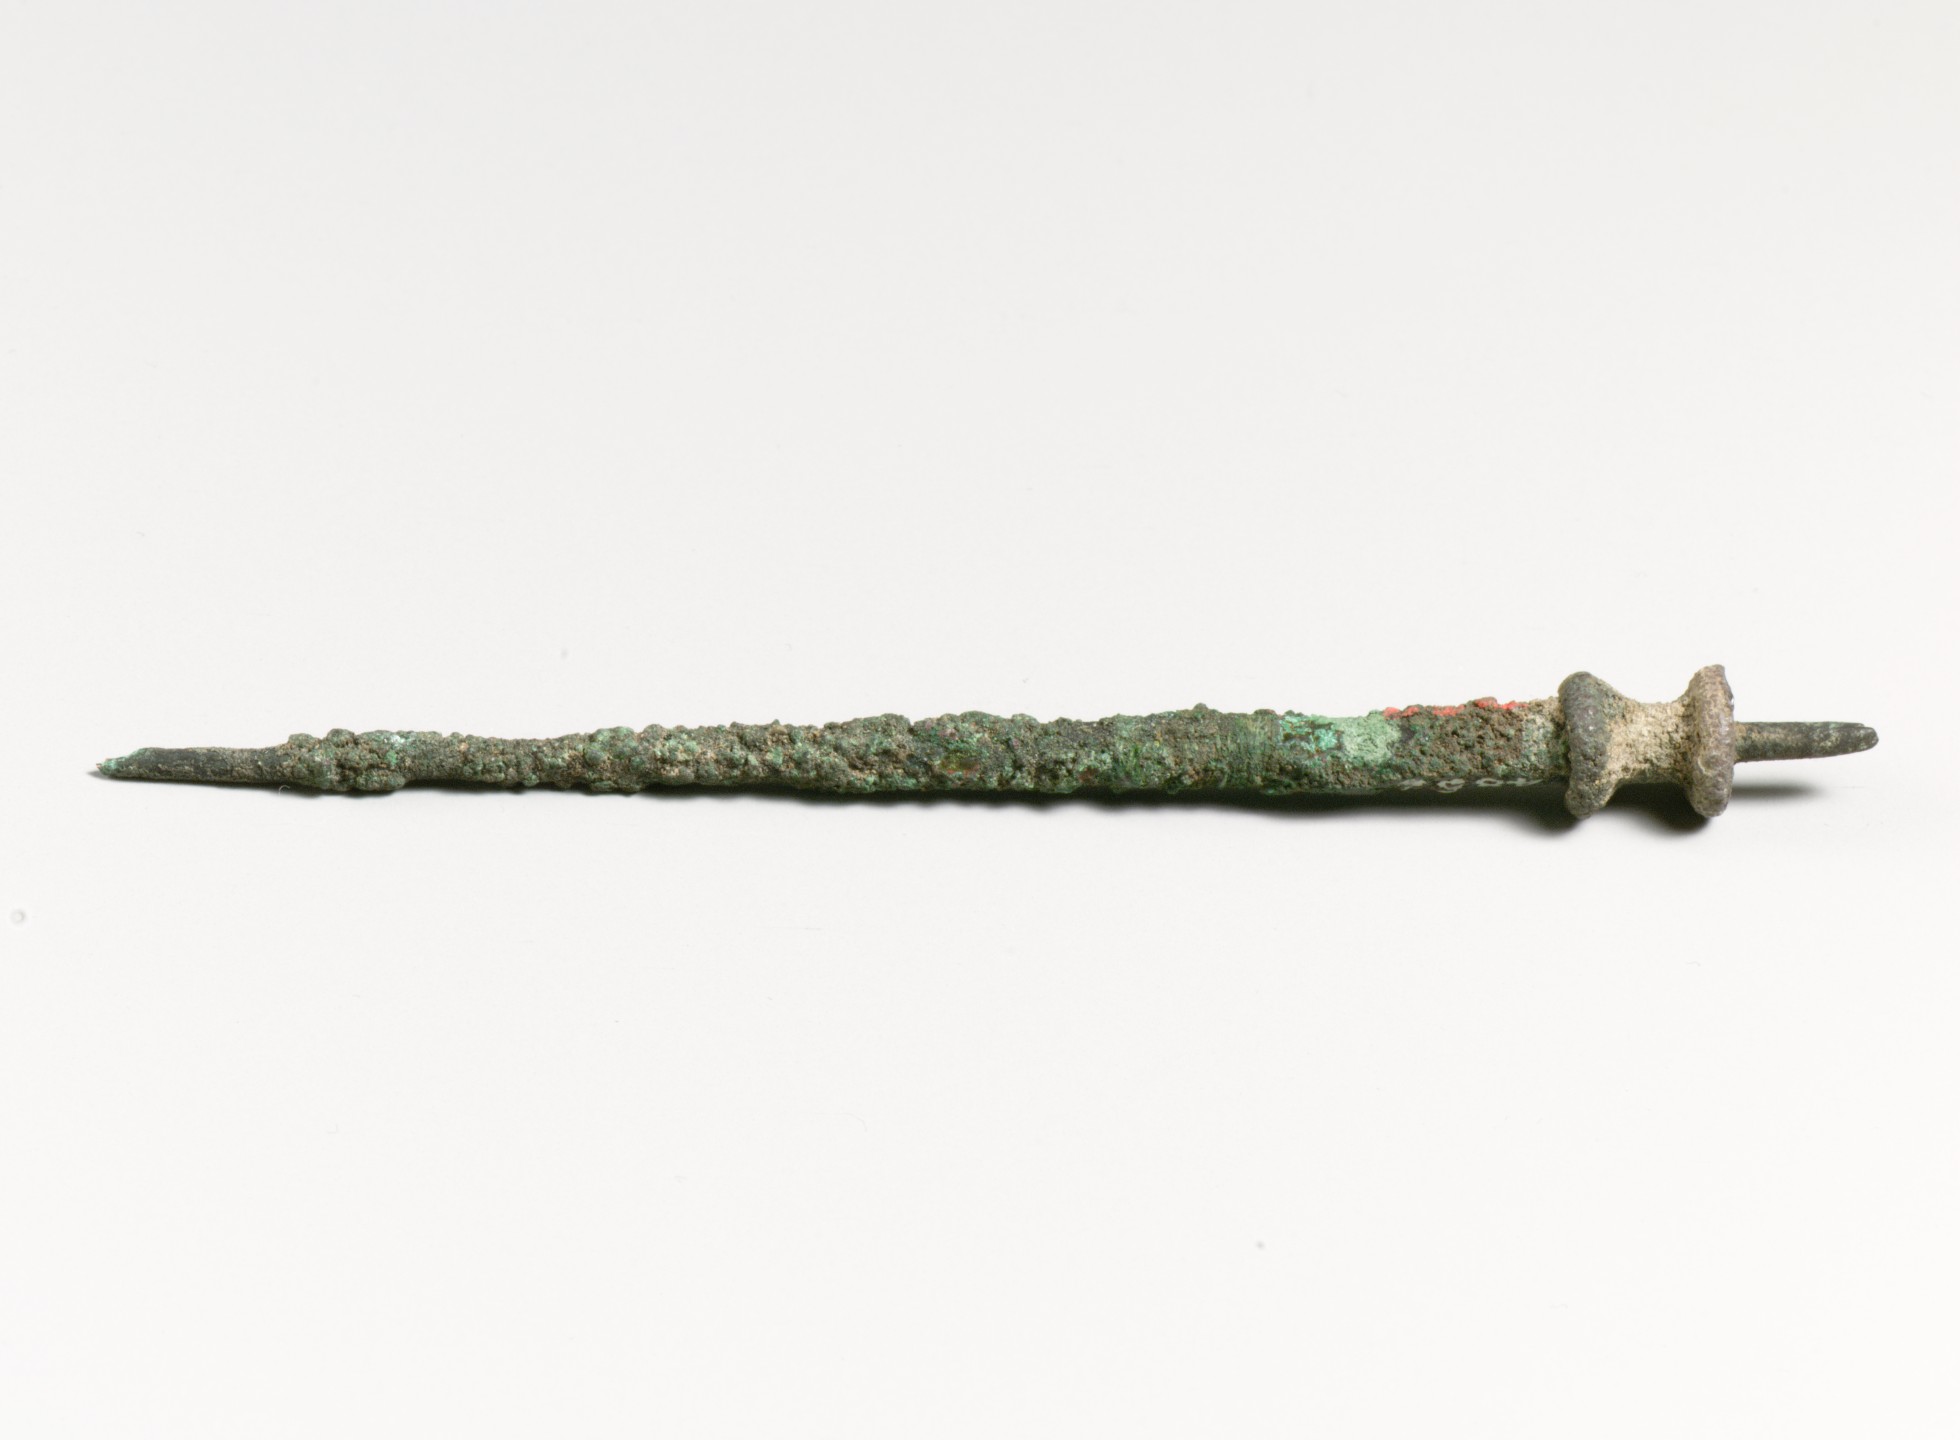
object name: pin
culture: roman, cypriot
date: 50-400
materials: bronze